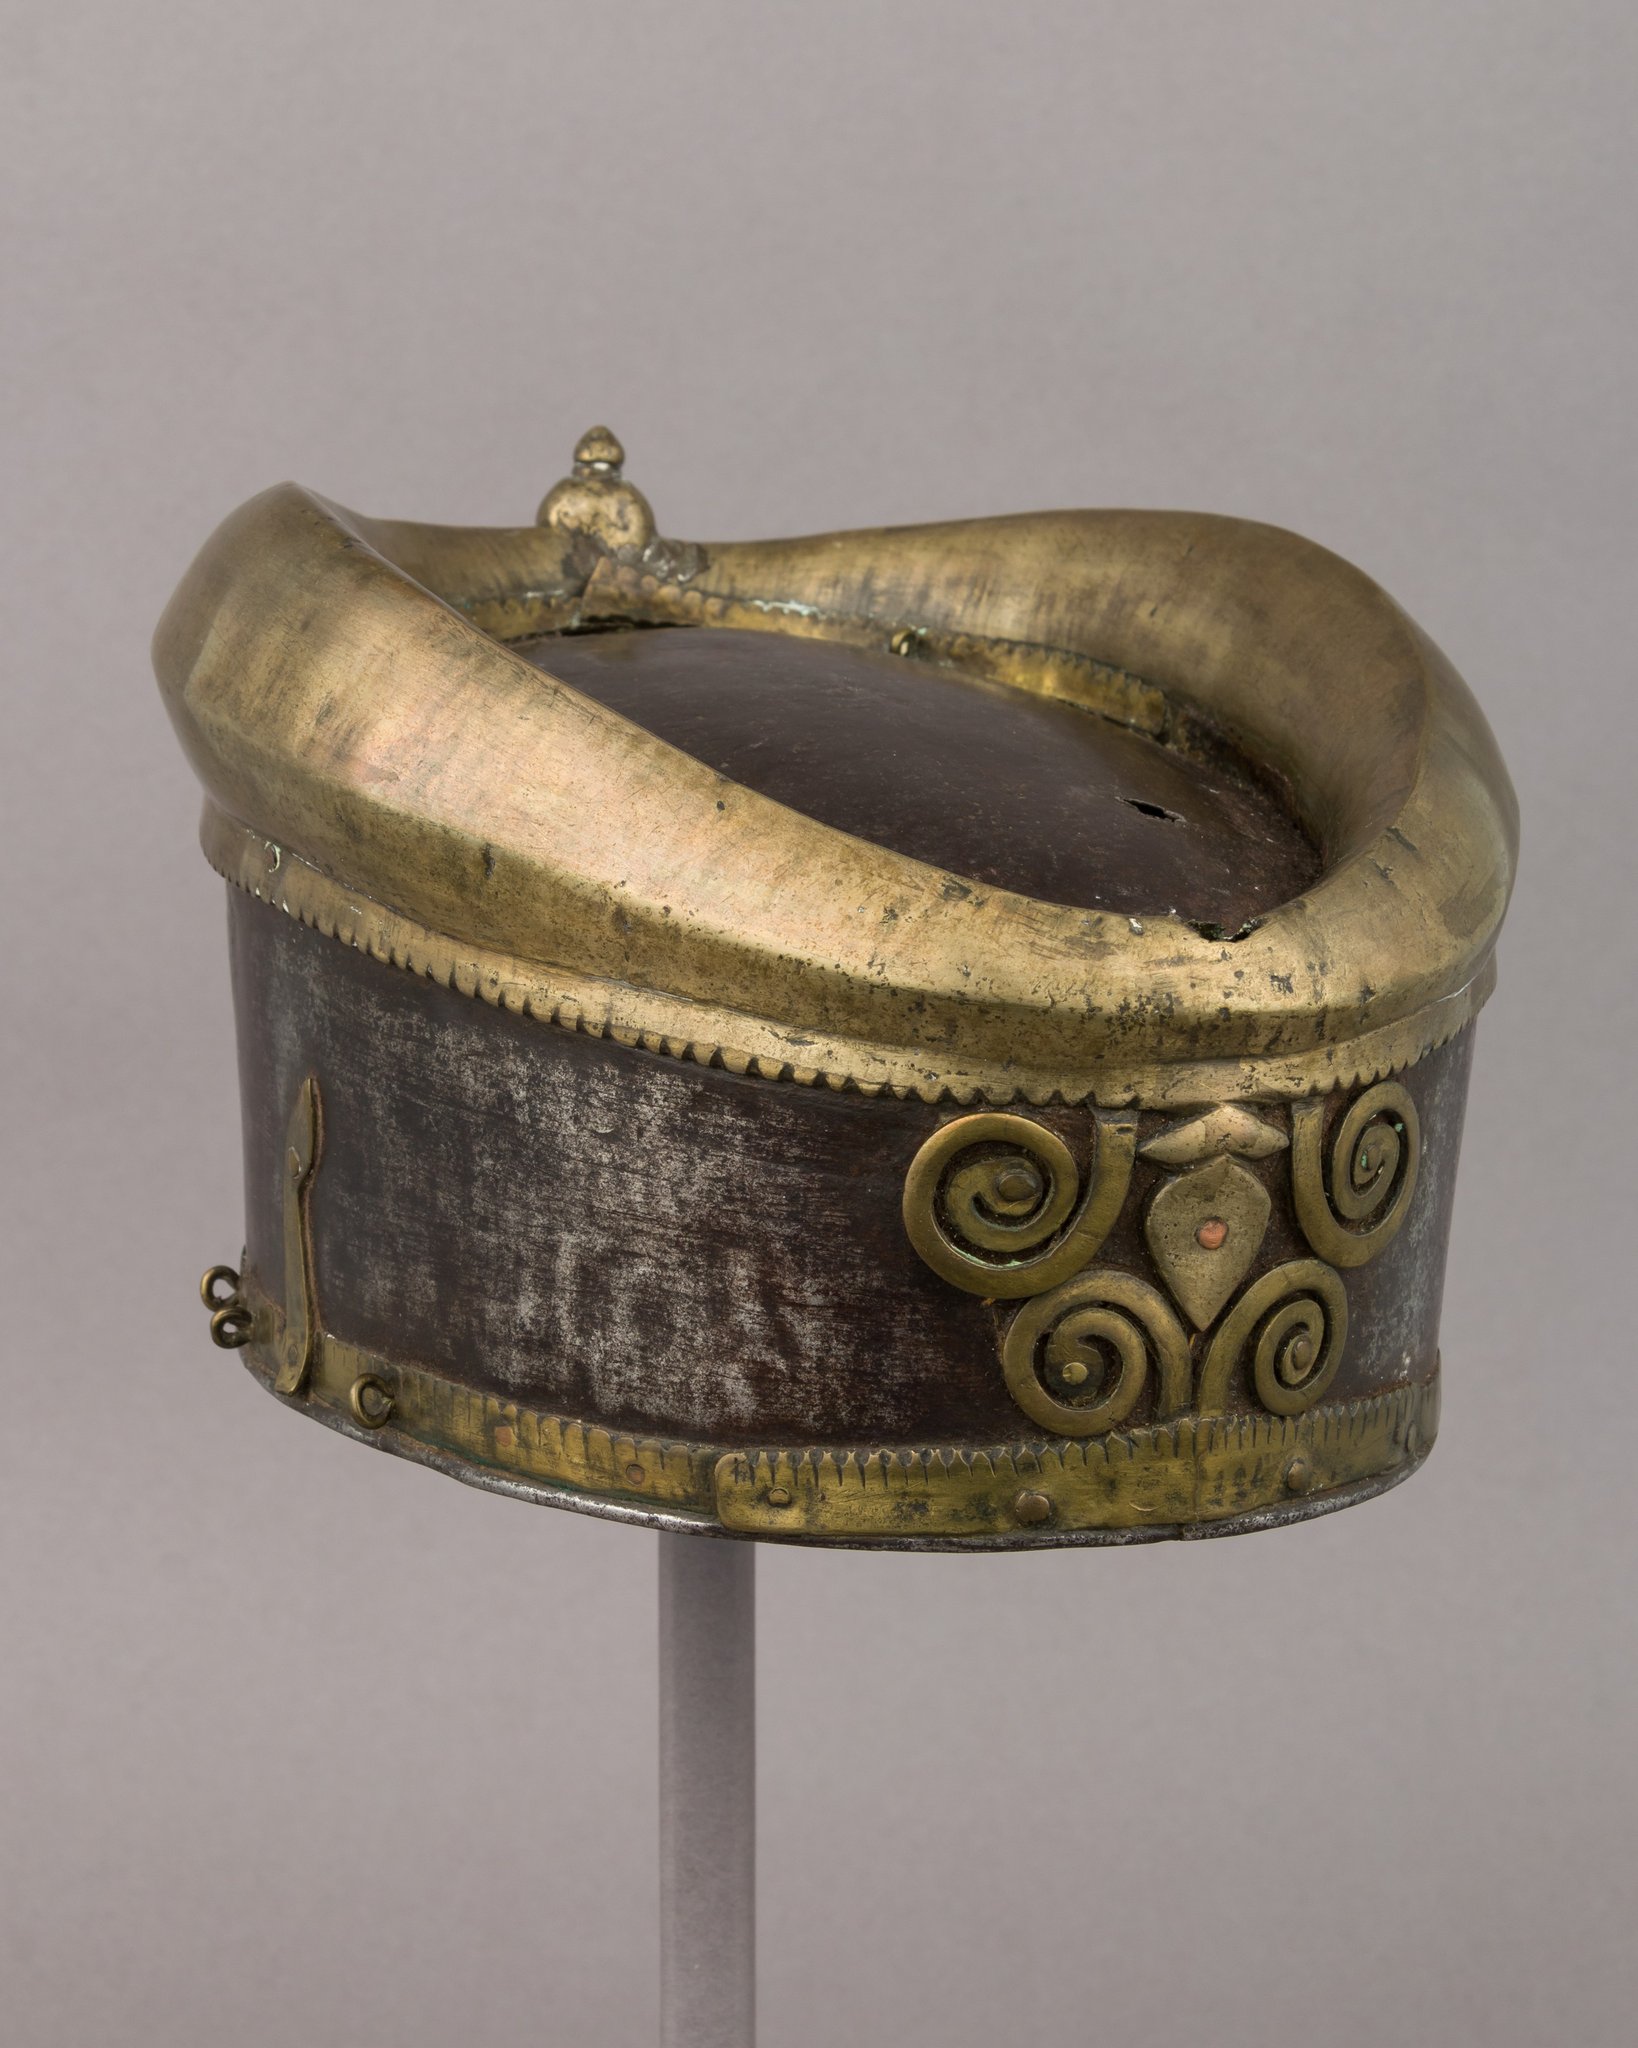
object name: helmet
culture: indian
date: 1801-1900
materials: brass, copper, steel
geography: north india